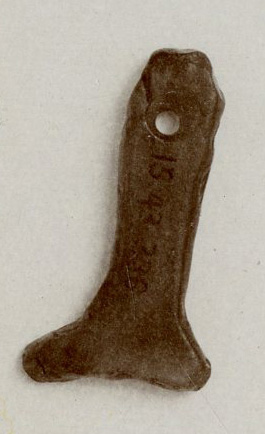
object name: amulet, leg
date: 2649-2030 BCE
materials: gemstone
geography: egypt